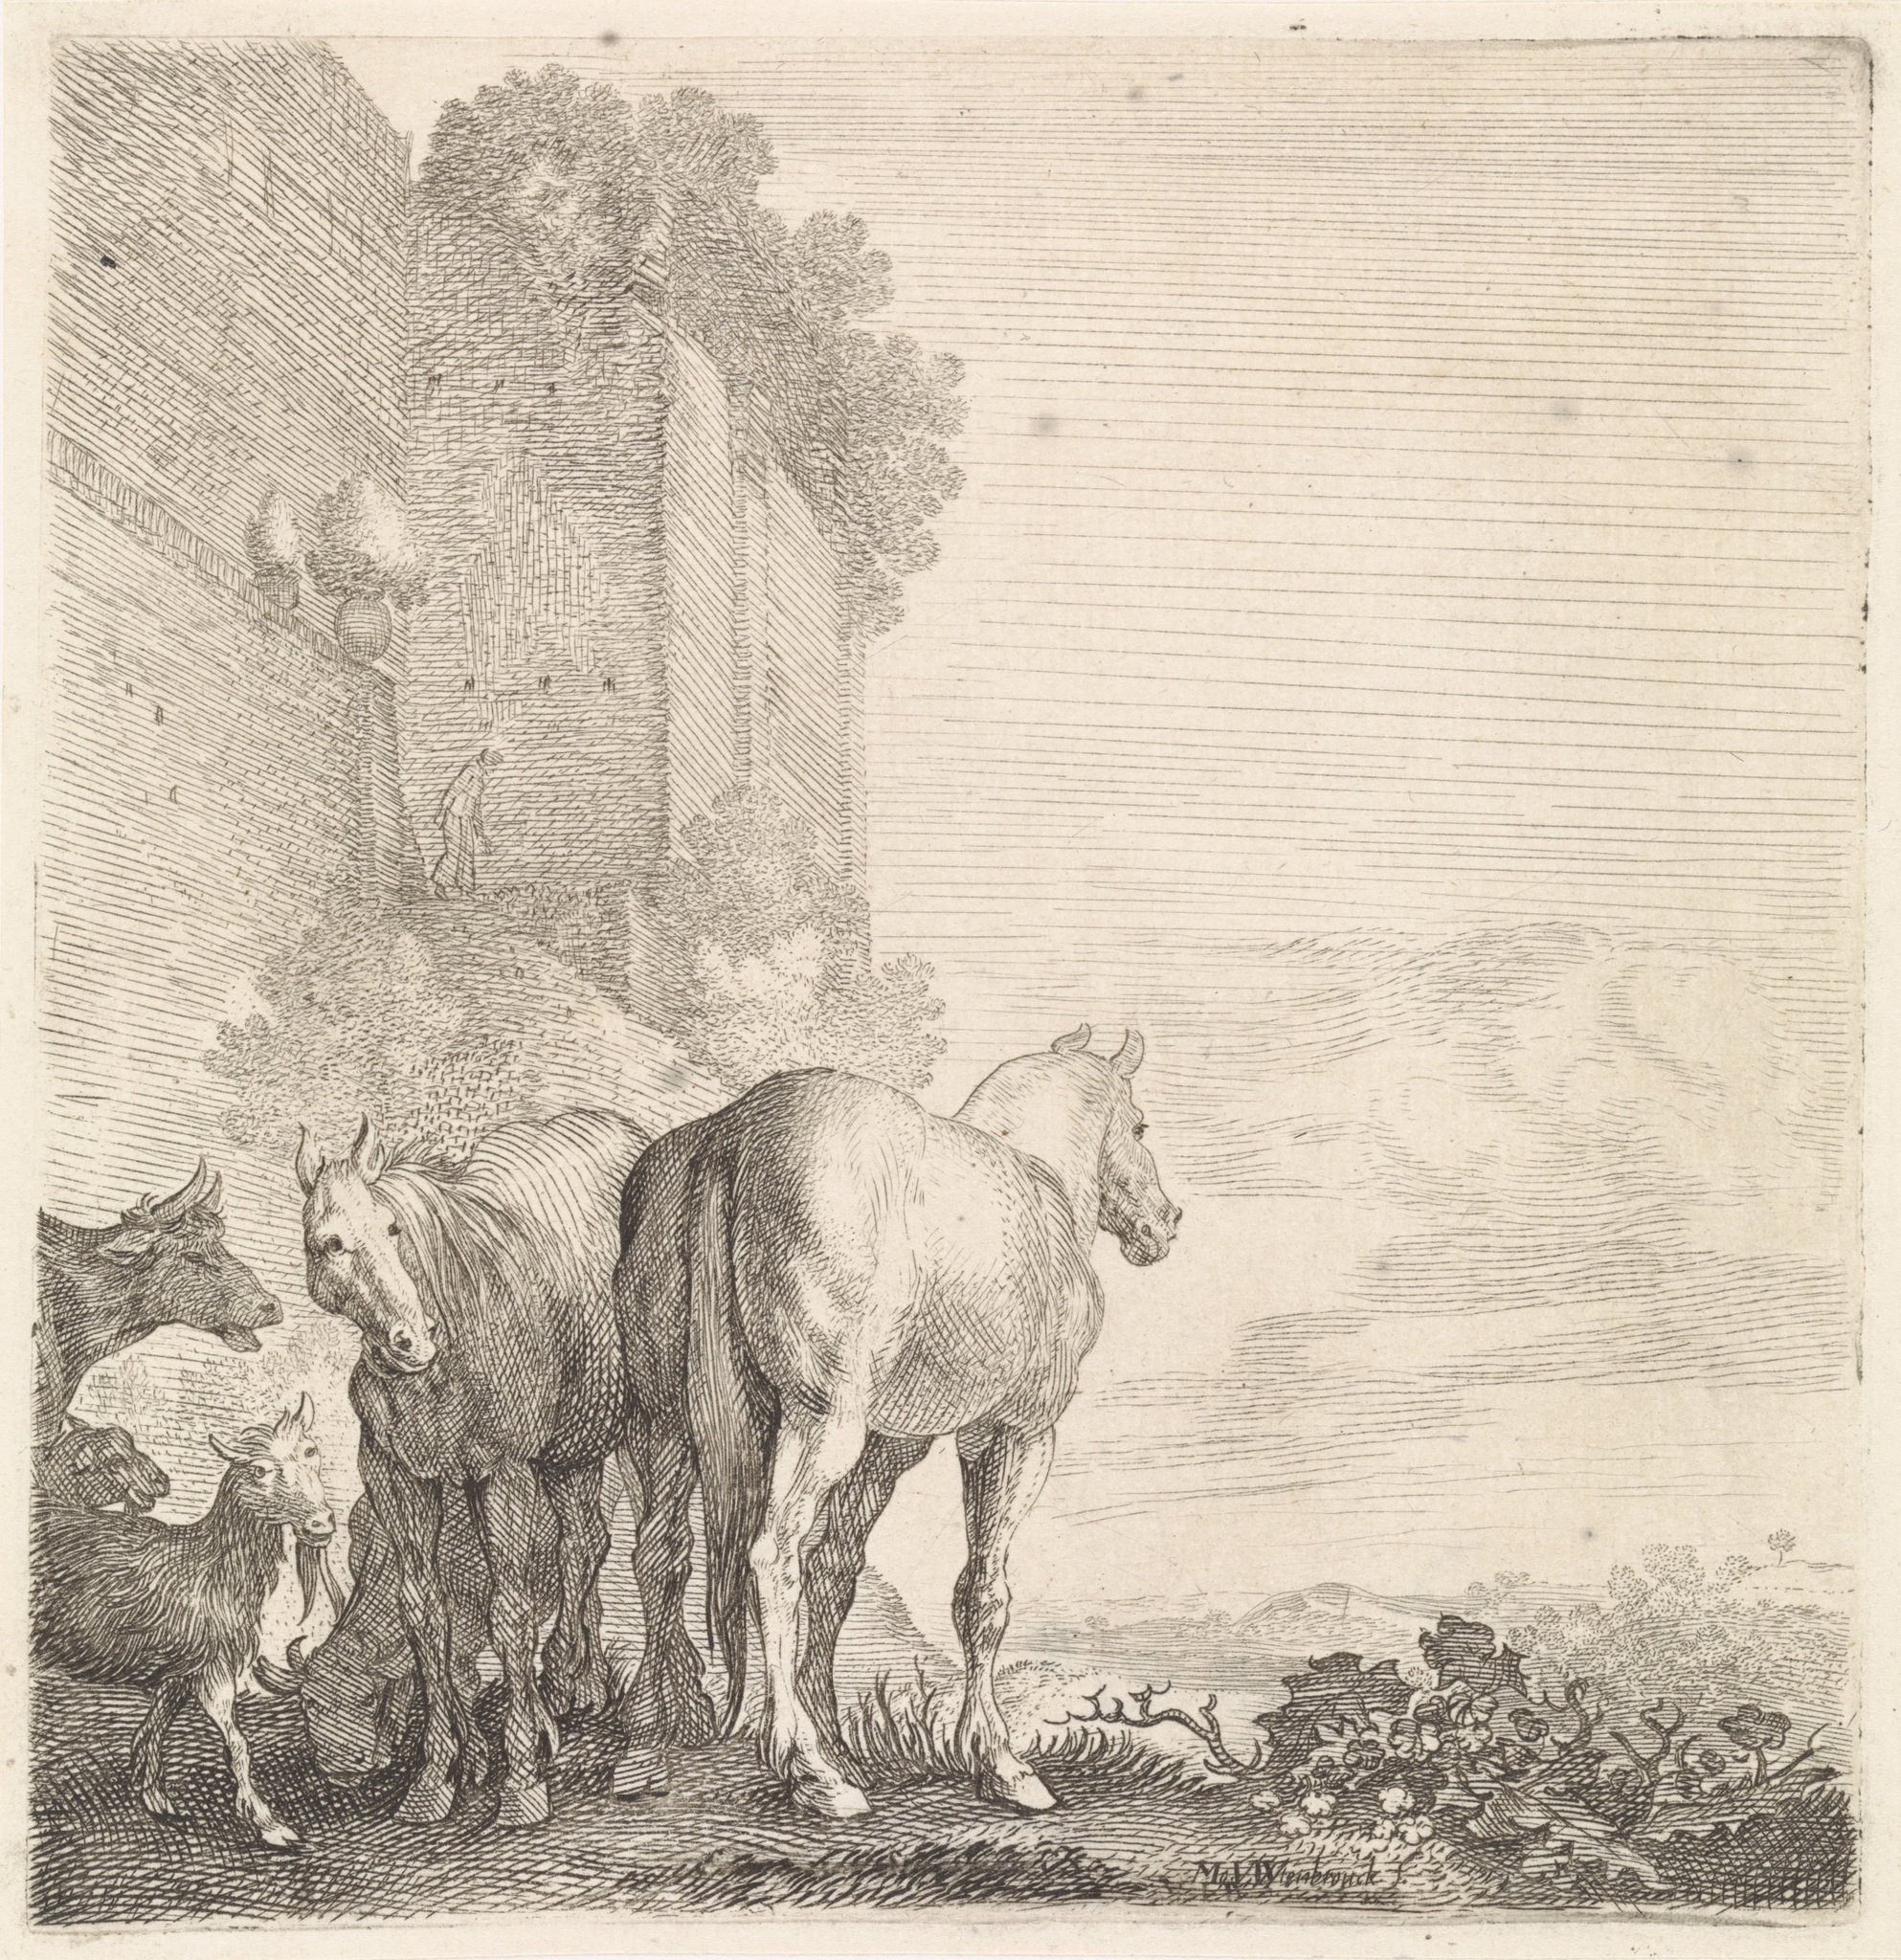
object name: print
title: Twee paarden met geiten en een koe bij een hoge (stads)muur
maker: moyses van wtenbrouck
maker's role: painter, print maker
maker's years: 1590-1647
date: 1600-1660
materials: paper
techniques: drypoint, engraving, etching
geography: the hague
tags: bovine cattle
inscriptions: collector's mark: Lugt 2228, collector's mark: Lugt 2610